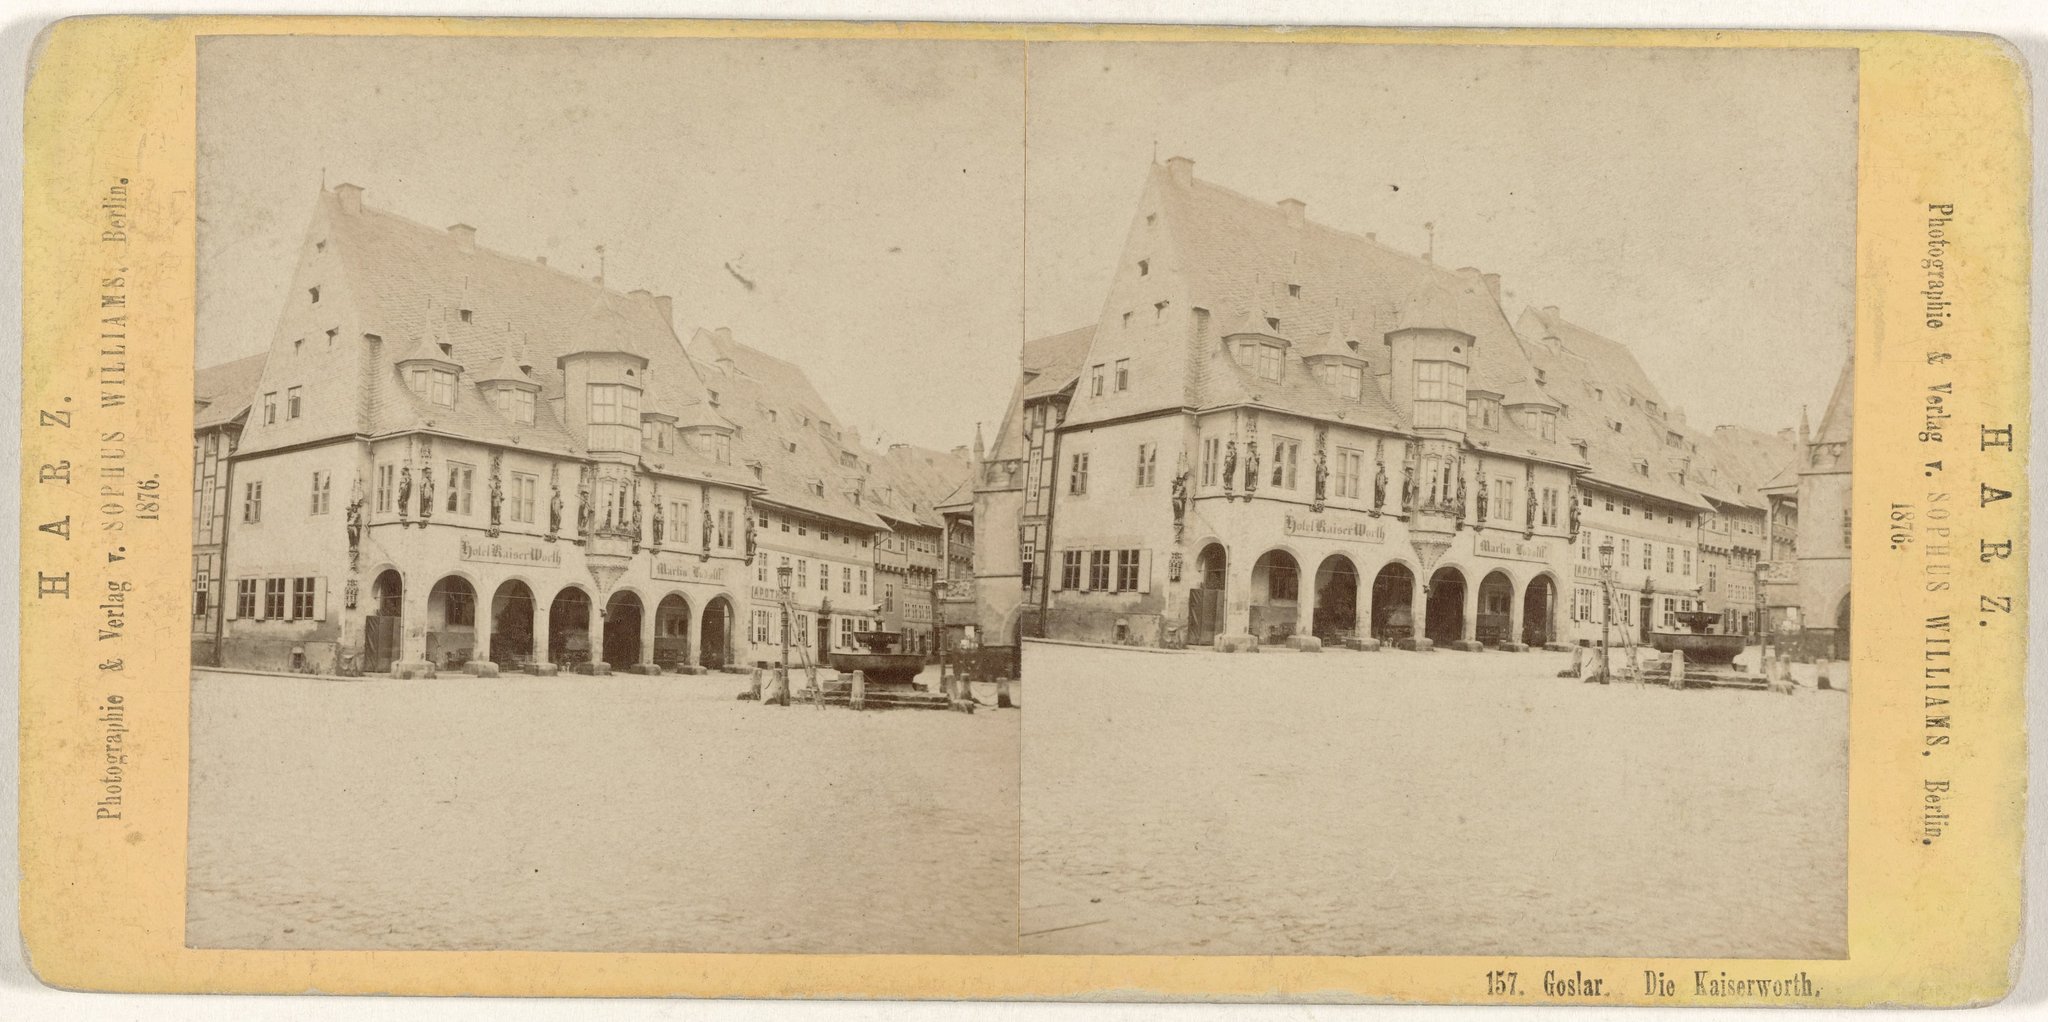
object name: stereograph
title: Goslar. Die Kaiserworth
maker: sophus williams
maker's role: publisher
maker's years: 1835-1900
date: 1876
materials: cardboard, paper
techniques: albumen print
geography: goslar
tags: square, place, circus, etc., exterior ~ representation of a building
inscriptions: number: ‘157.’